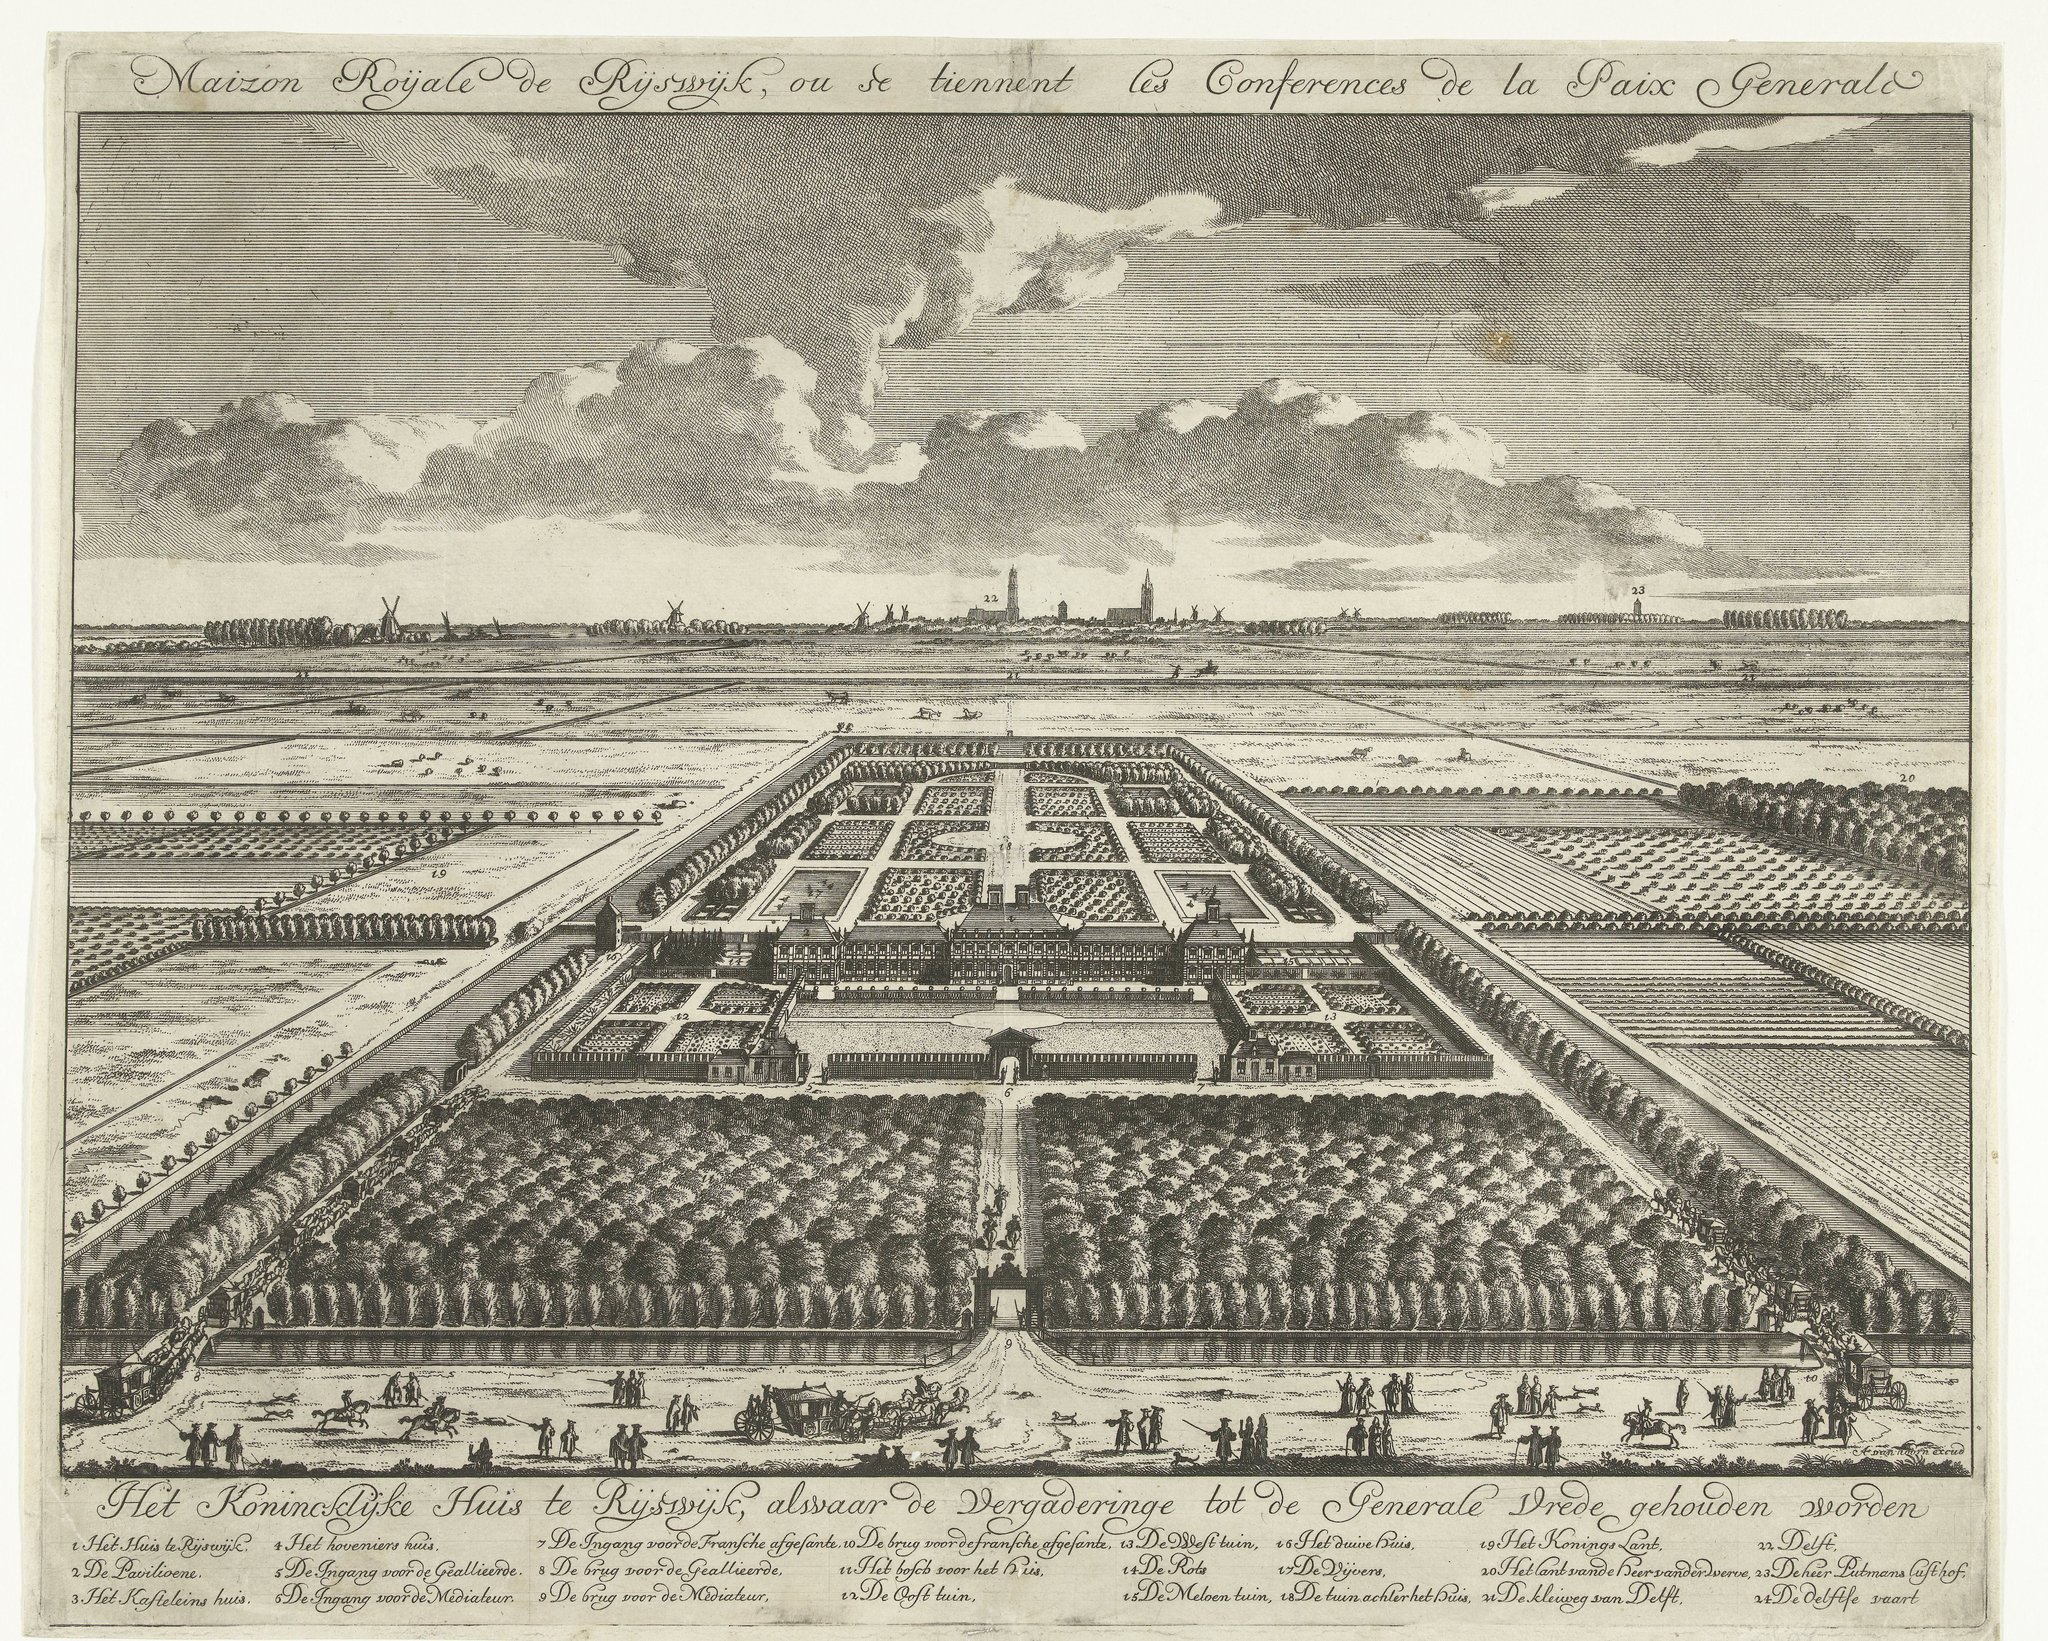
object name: print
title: Gezicht op de tuinen bij het Huis ter Nieuburch in Rijswijk, 1697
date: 1697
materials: paper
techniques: etching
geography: northern netherlands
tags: garden, palace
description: Gezicht in vogelvluchtperspectief op het Huis ter Nieuburch met de tuinen te Rijswijk. Op de voorgrond de weg uit Den Haag met de drie bruggen en de drie aparte ingangen tot het paleis, in het verschiet Delft. In het onderschrift de legenda 1-24 in het Nederlands.